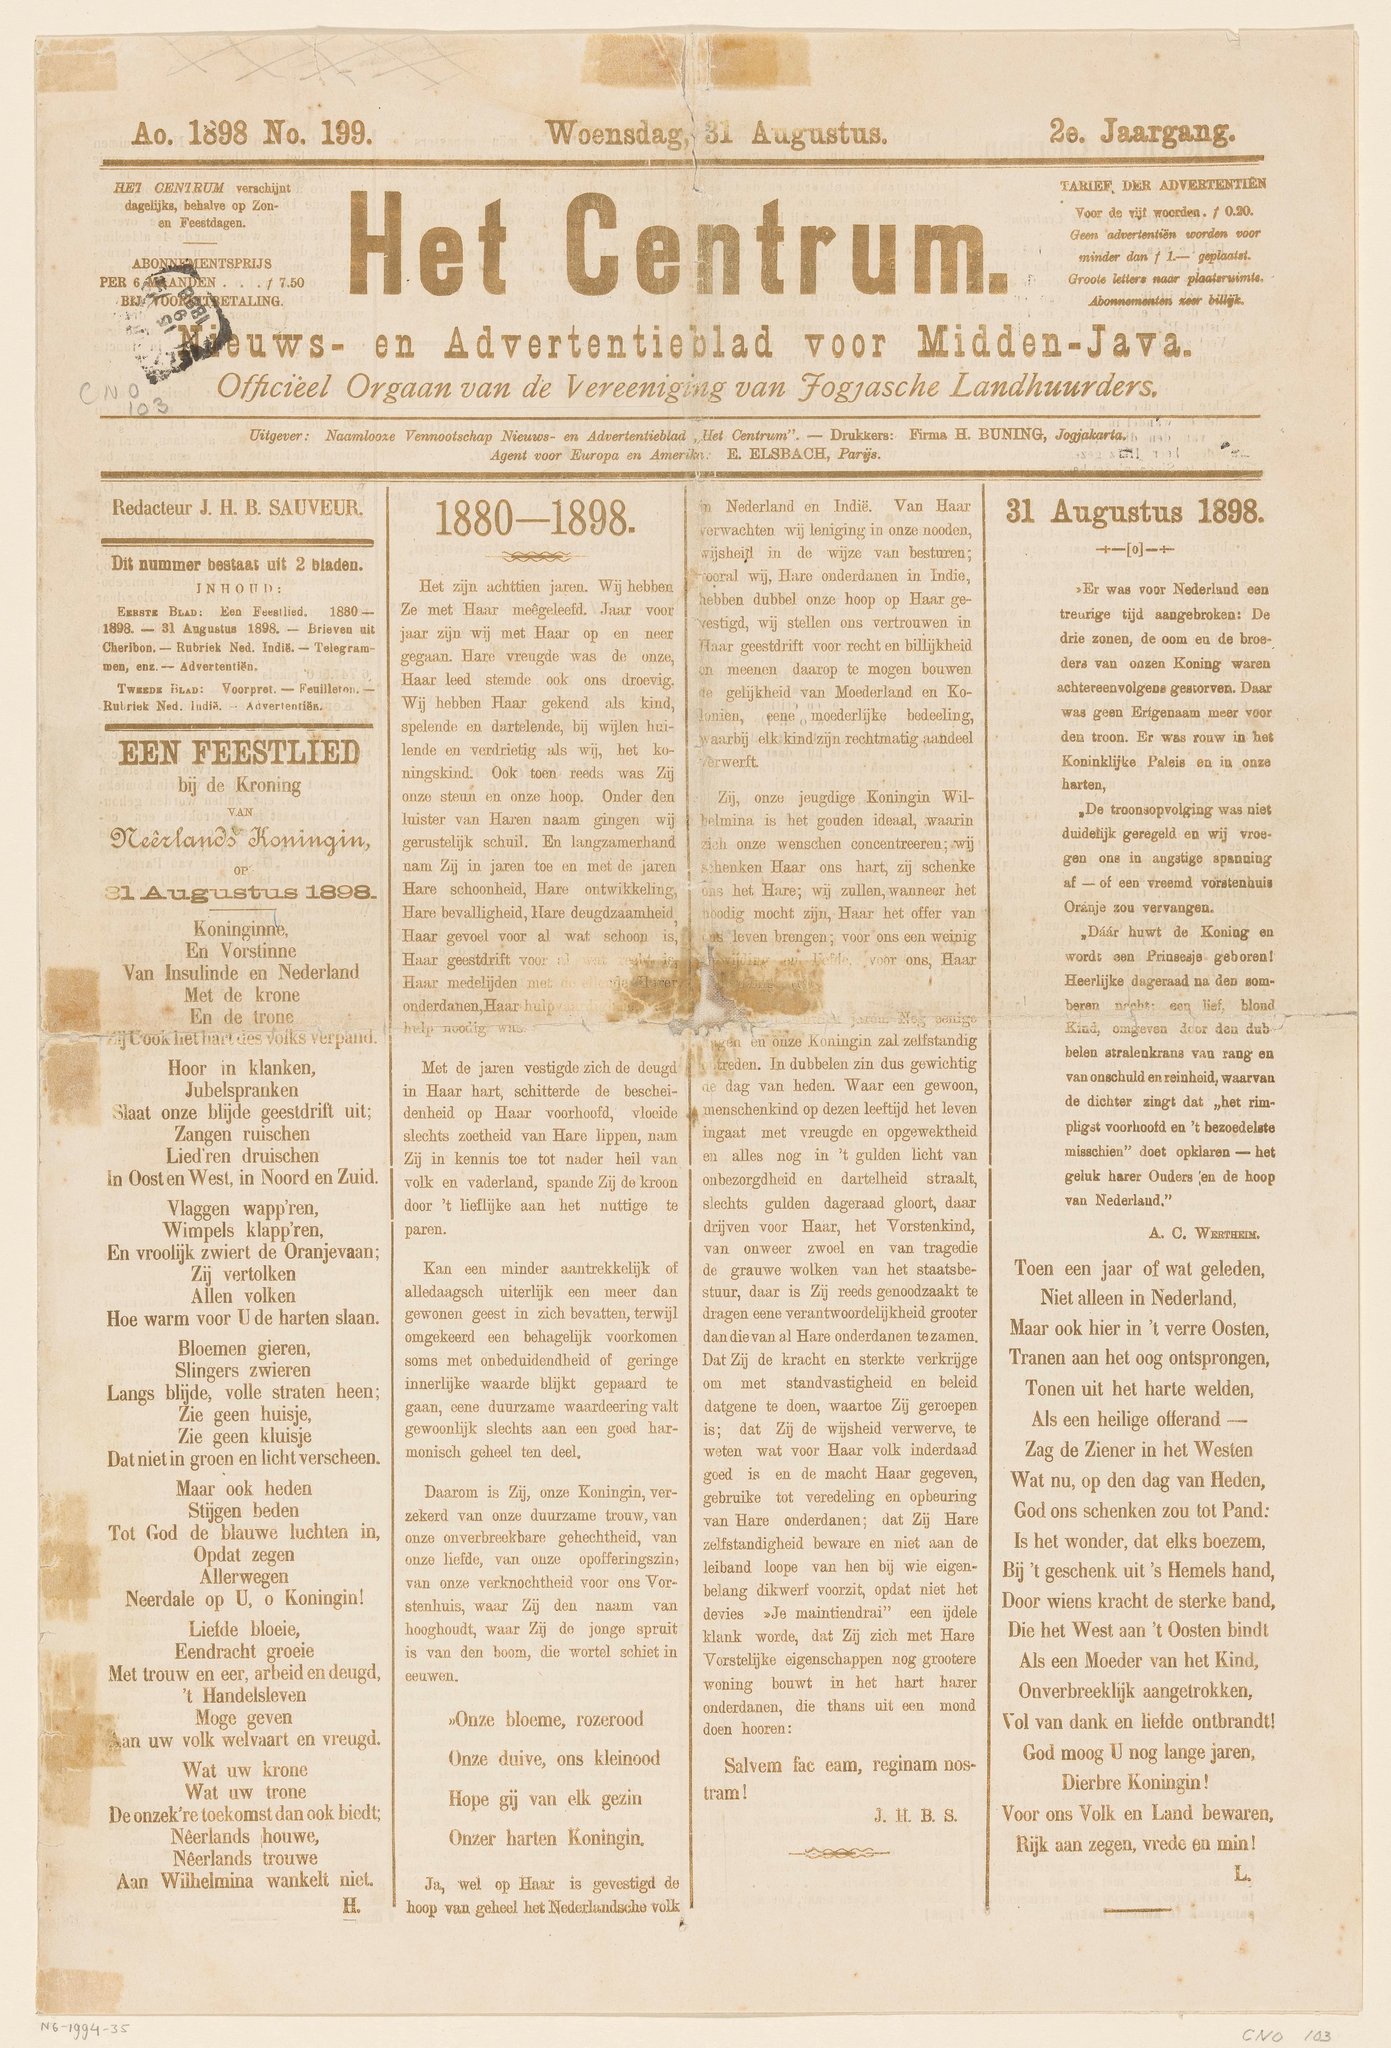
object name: newspaper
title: Het Centrum: Nieuws- en Advertentieblad voor Midden Java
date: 1898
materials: paper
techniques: printing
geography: jogjakarta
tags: the hague, wilhelmina of the netherlands, public festivities on the occasion of royal events, newspaper, news-sheet, java, amsterdam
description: Krant van woensdag 31 augustus 1898. Het exemplaar is in goud gedrukt vanwege de kroning van koningin Wilhelmina.